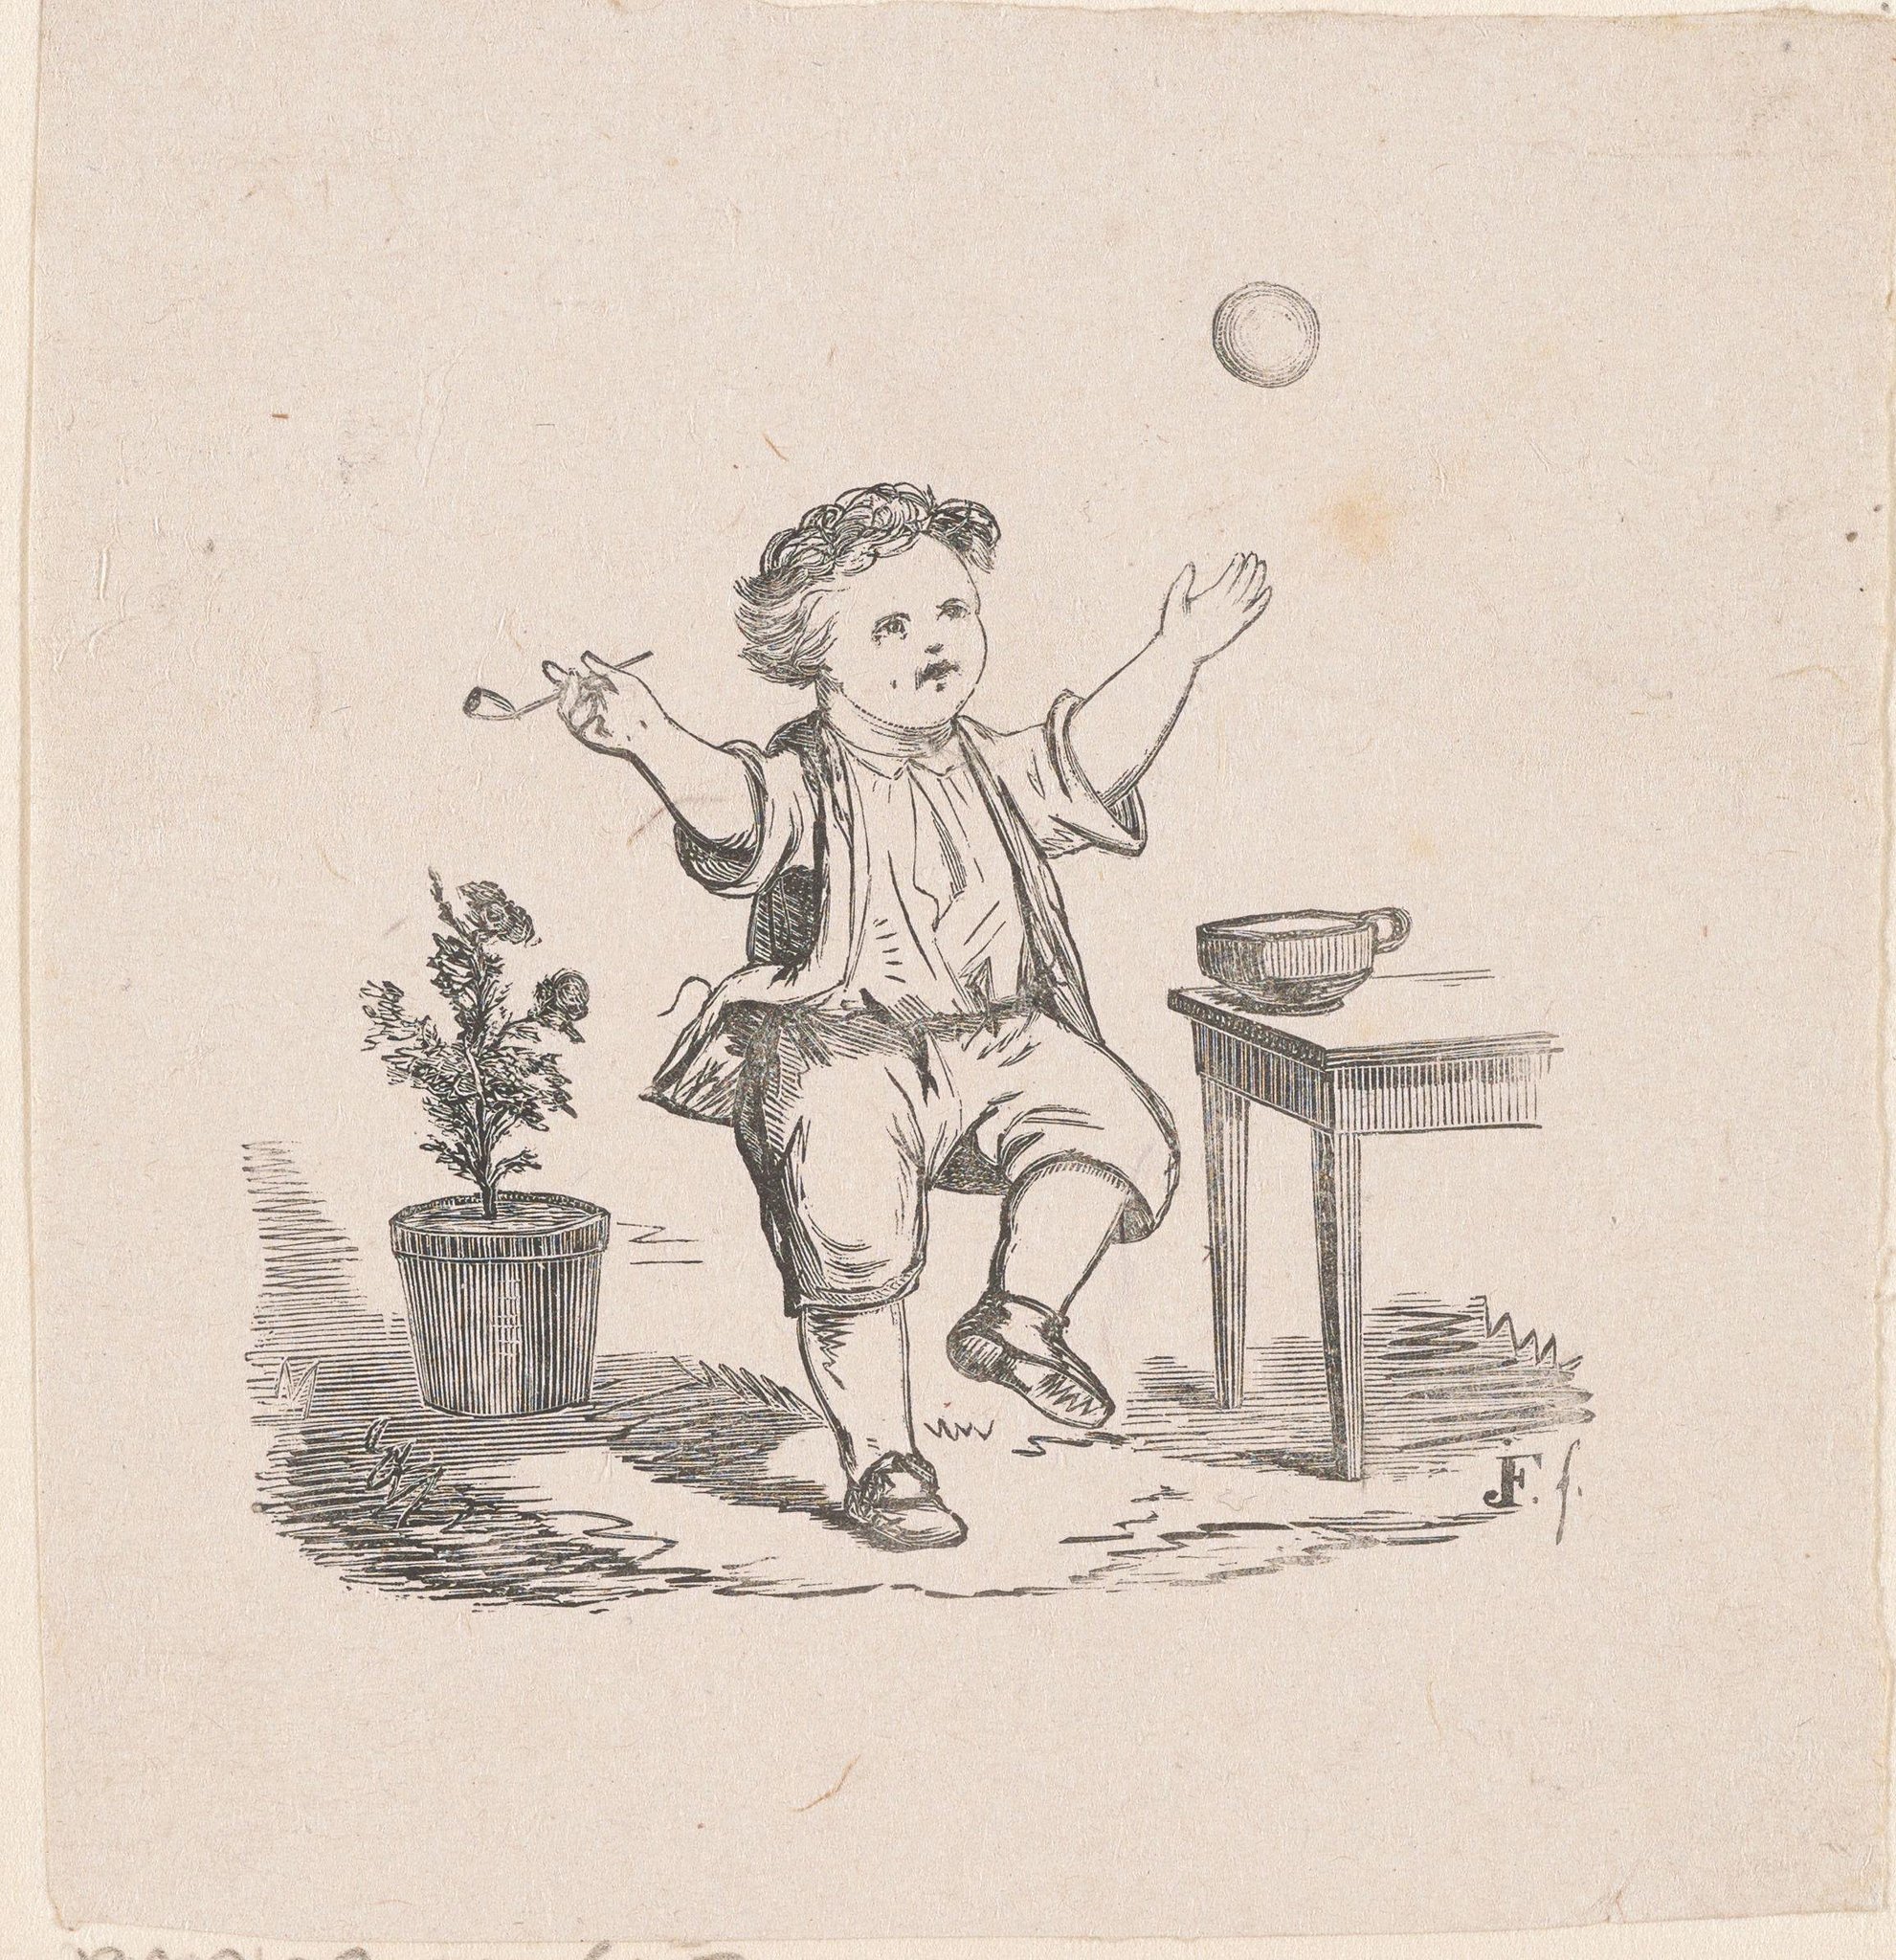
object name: print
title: Bellenblazende jongen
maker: isaac weissenbruch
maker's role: print maker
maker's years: 1826-1912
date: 1836-1912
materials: paper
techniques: engraving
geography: netherlands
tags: bubble-blowing (children's games and plays)